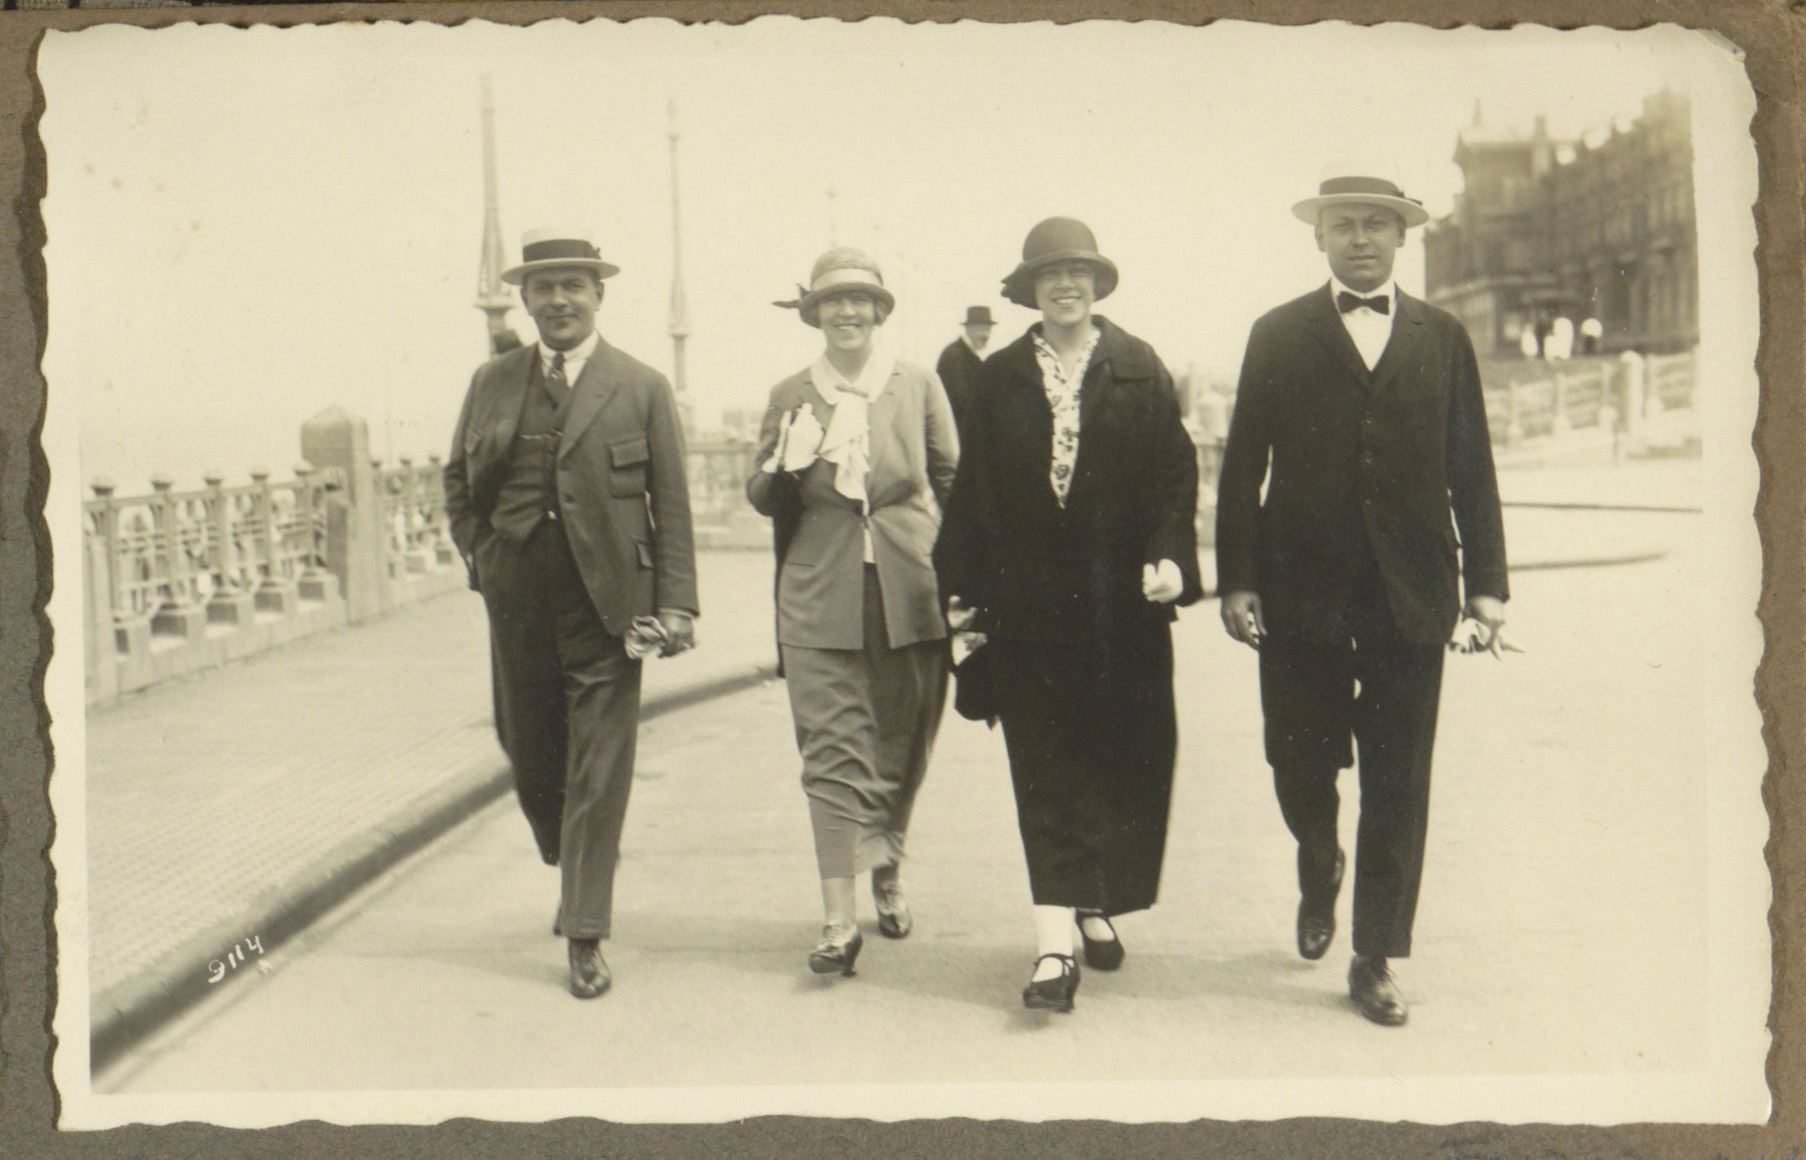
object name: photograph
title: Zondagmorgen op de Boulevard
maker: Anonymous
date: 1905-1924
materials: photographic support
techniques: gelatin silver print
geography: scheveningen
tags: adult woman, strolling, adult man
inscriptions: number: ‘9114’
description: Onderdeel van fotoalbum van een onbekende Nederlandse familie met opnames van Suriname, Europa en Nederlands-Indië.